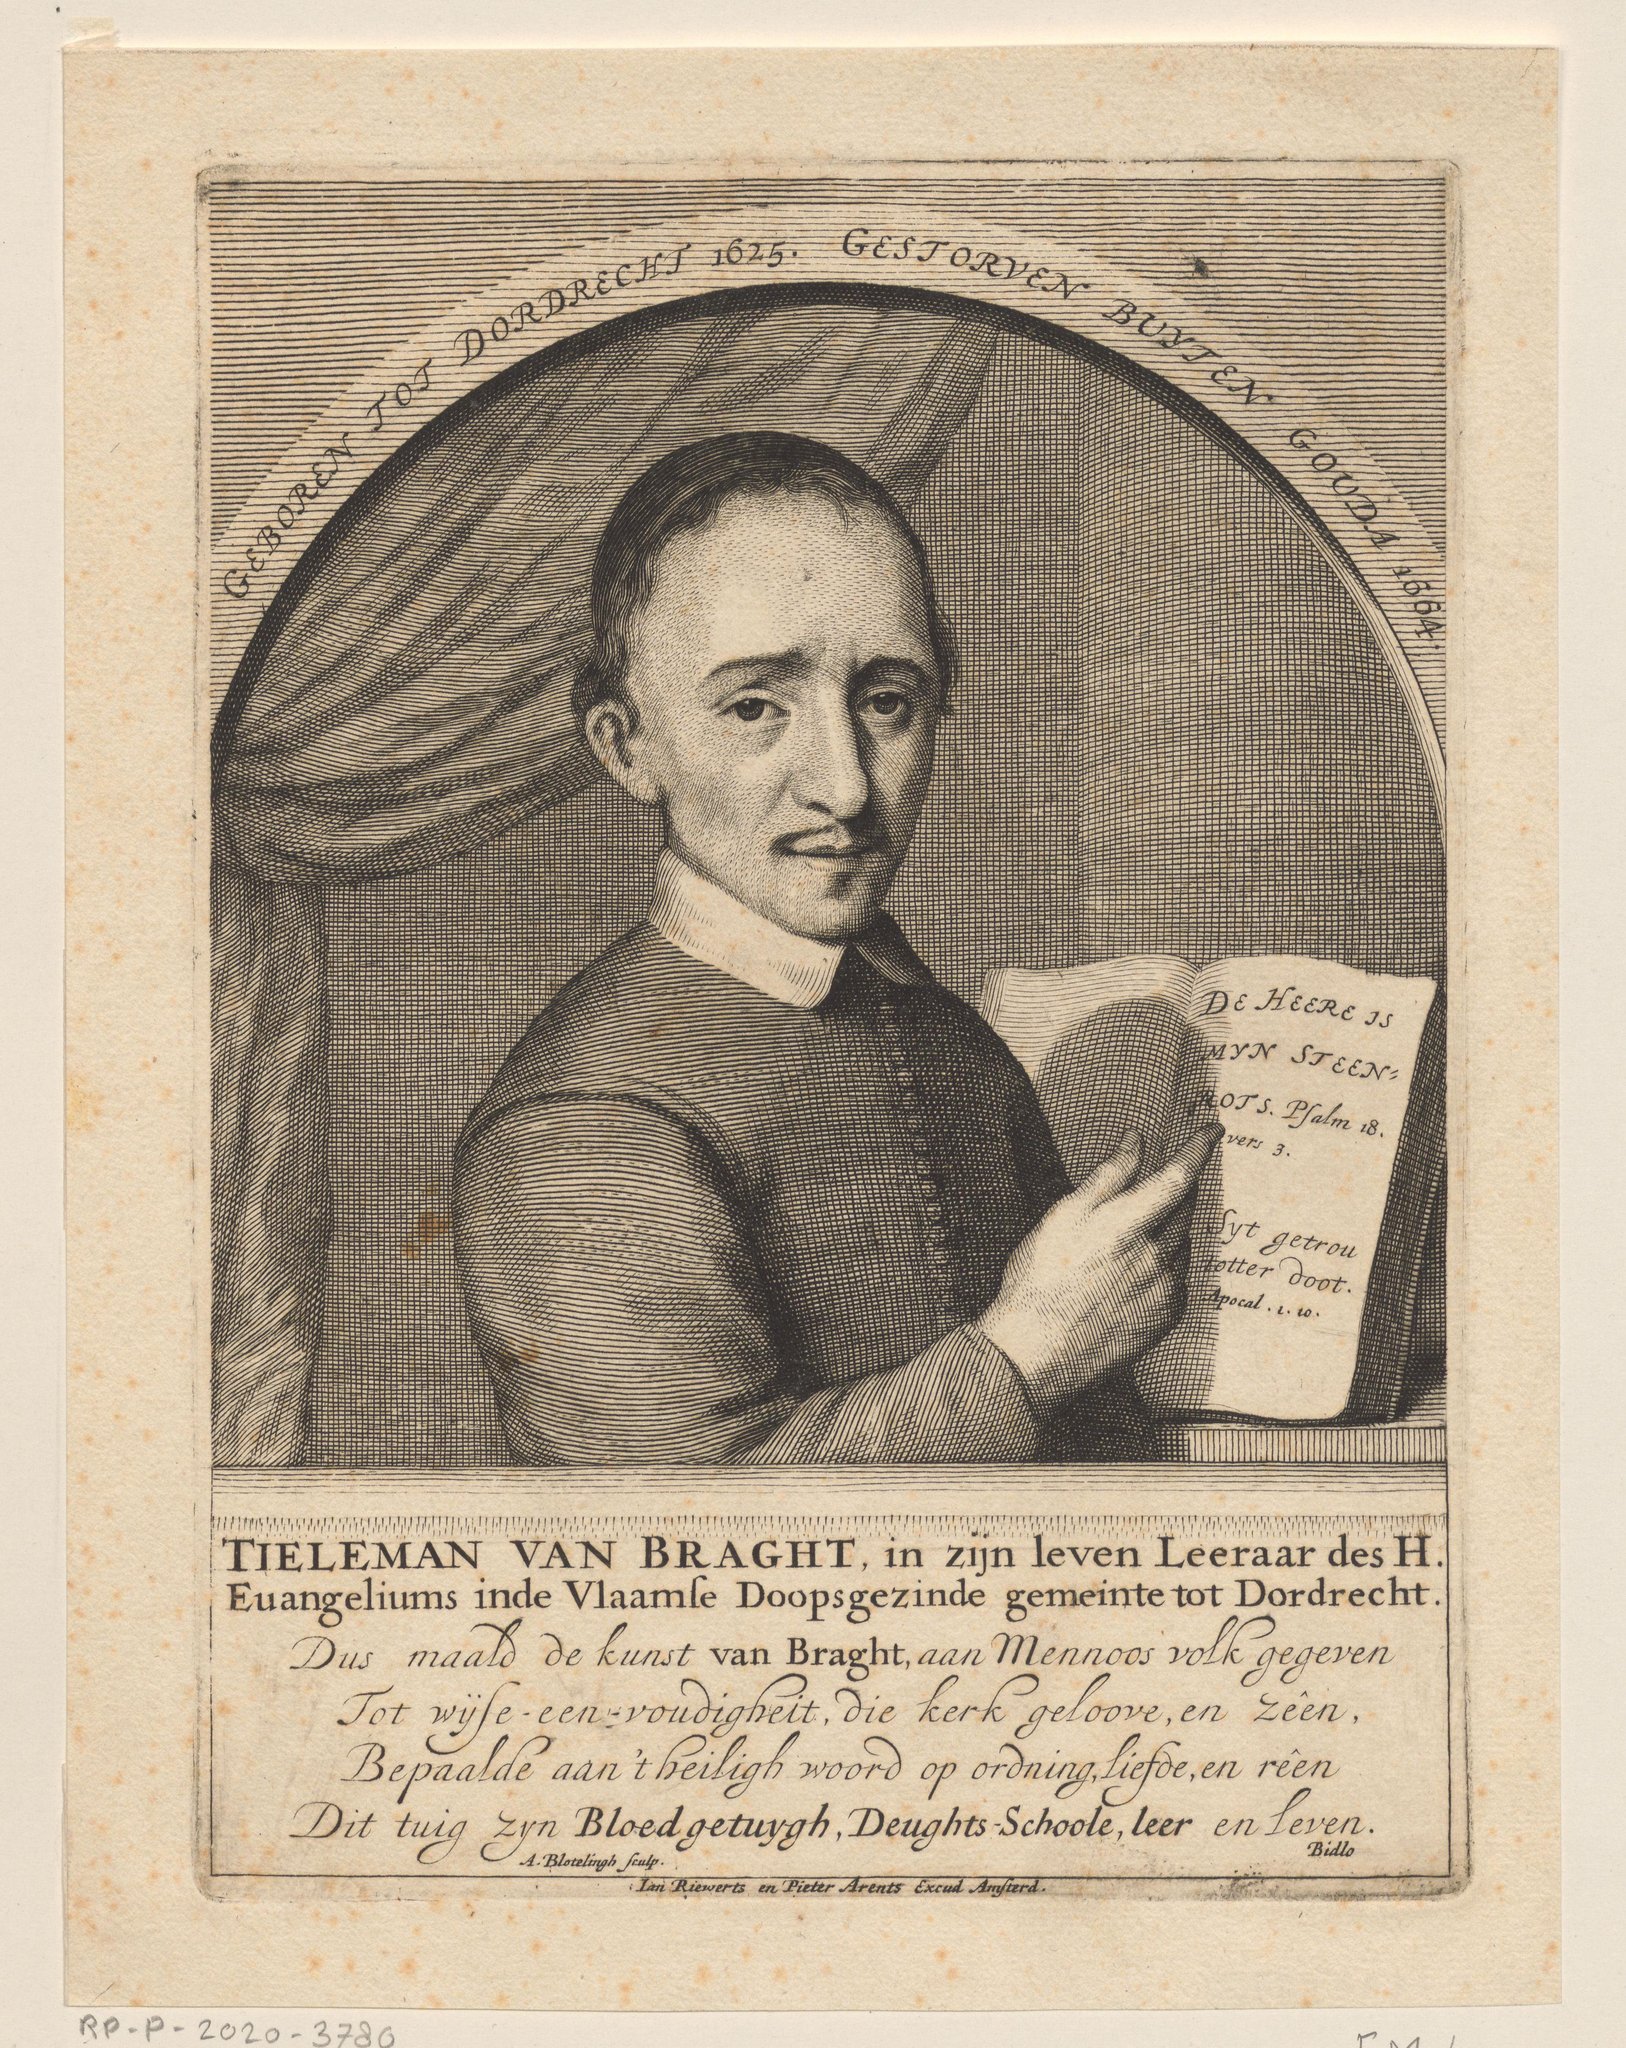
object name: print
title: Portret van Tieleman van Bracht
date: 1664-1690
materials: paper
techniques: engraving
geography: amsterdam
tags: historical persons, book